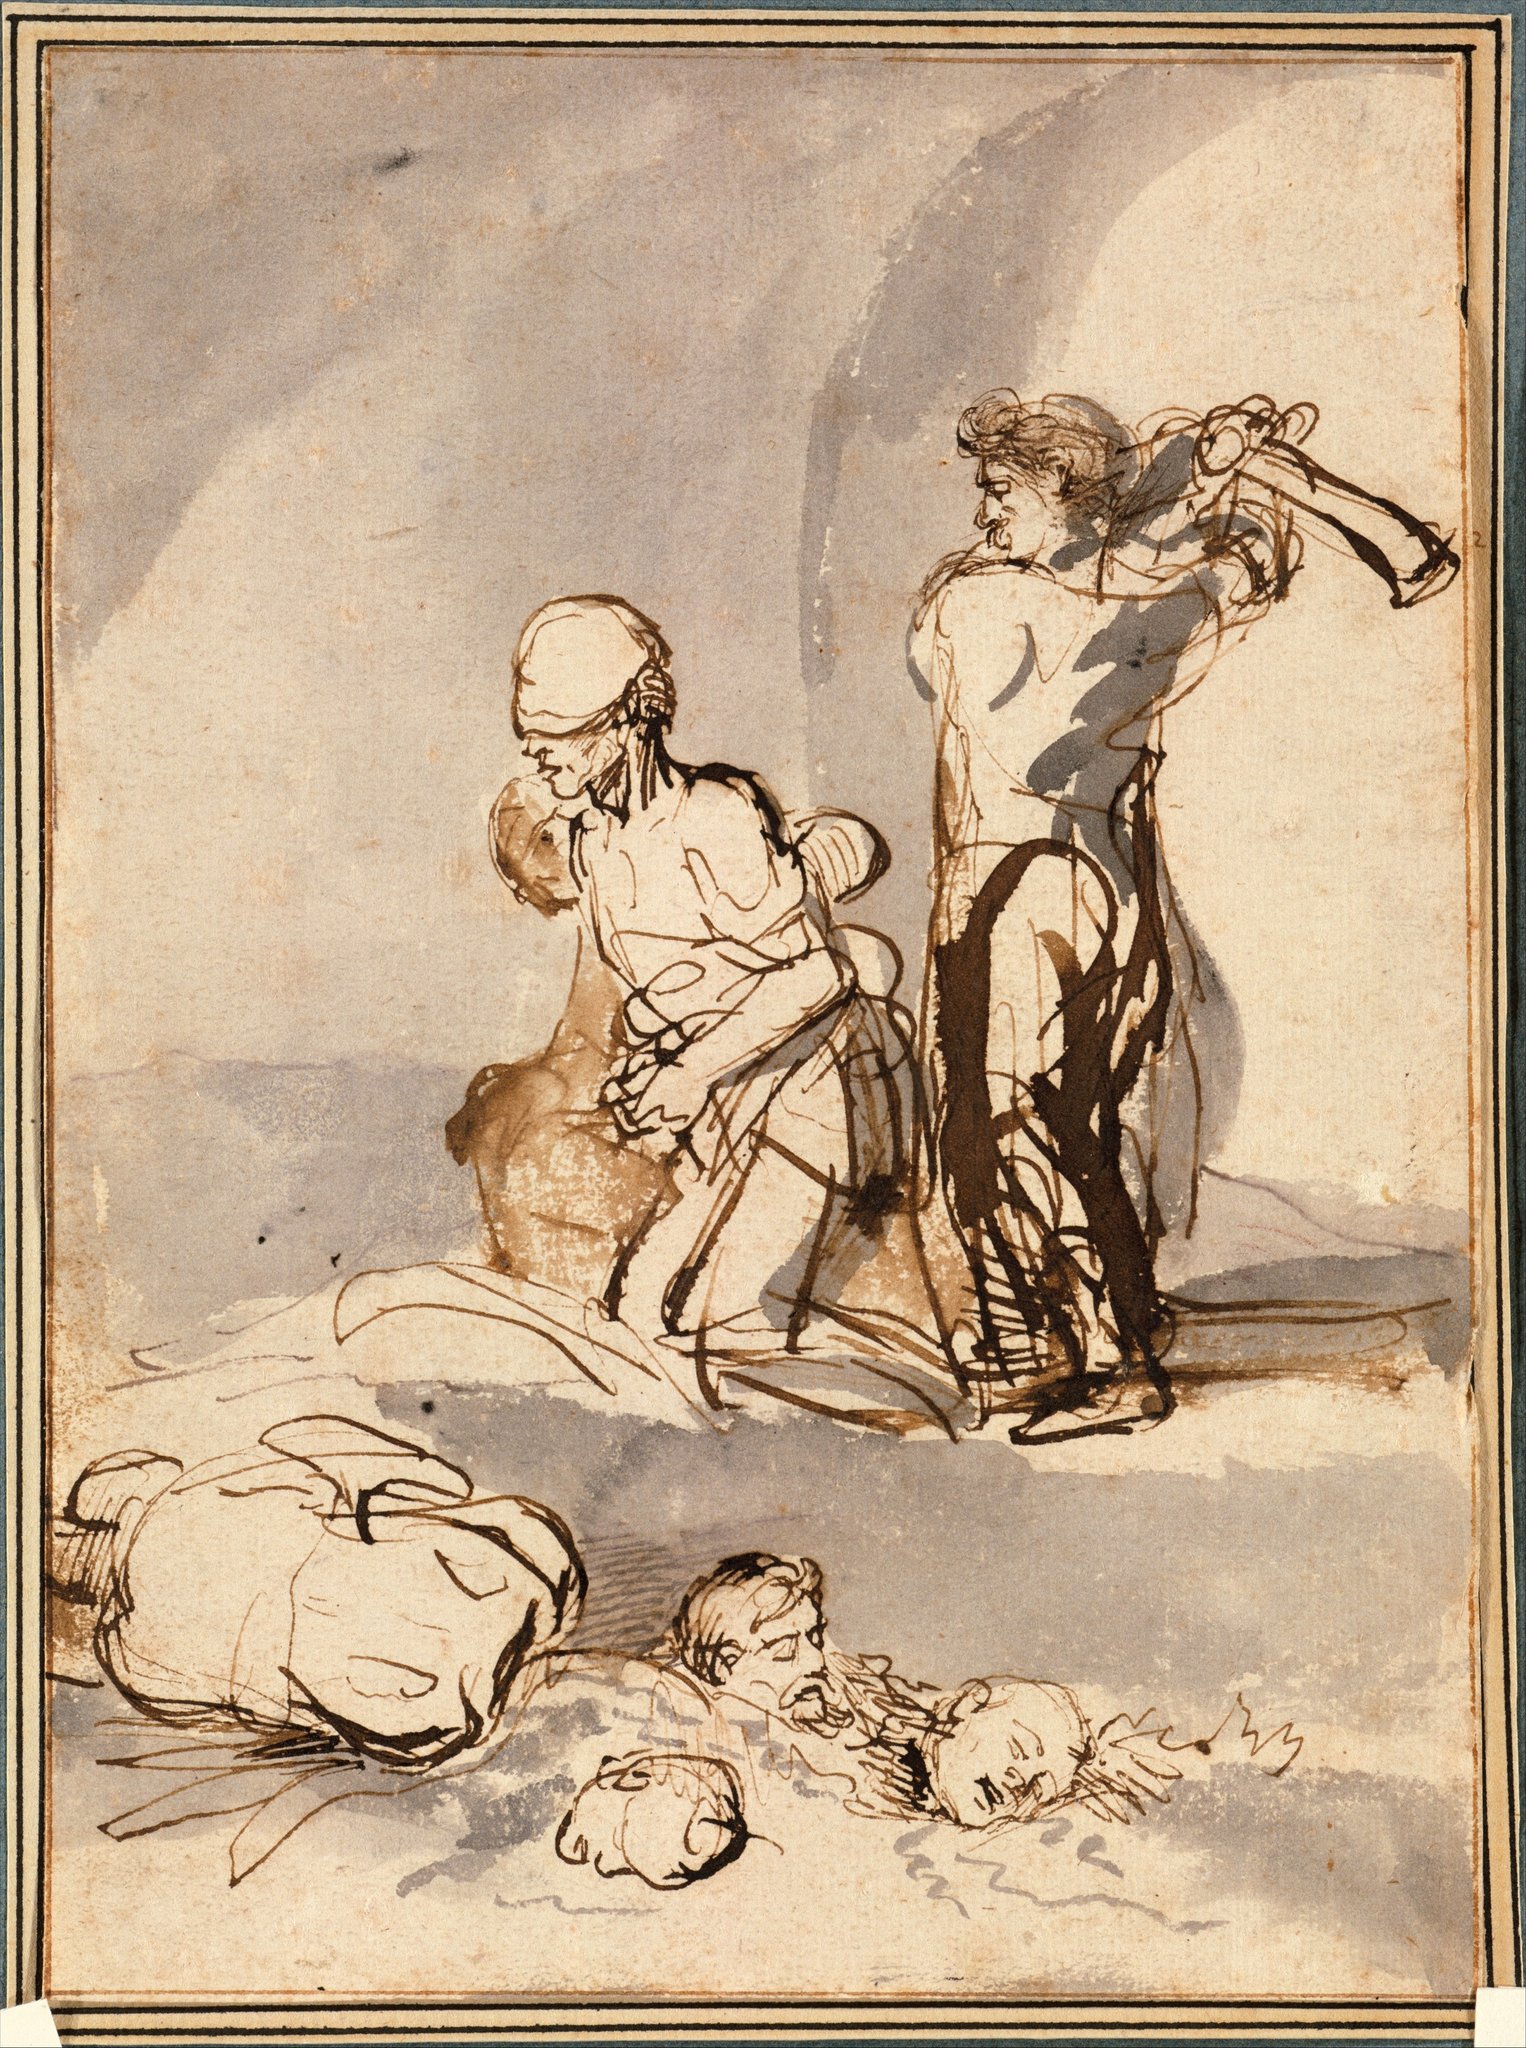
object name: drawing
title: Beheading of Anabaptist Martyrs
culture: dutch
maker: school of rembrandt van rijn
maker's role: artist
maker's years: 1606-1669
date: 1640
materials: ink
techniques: brush, pen, wash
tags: heads,men,execution